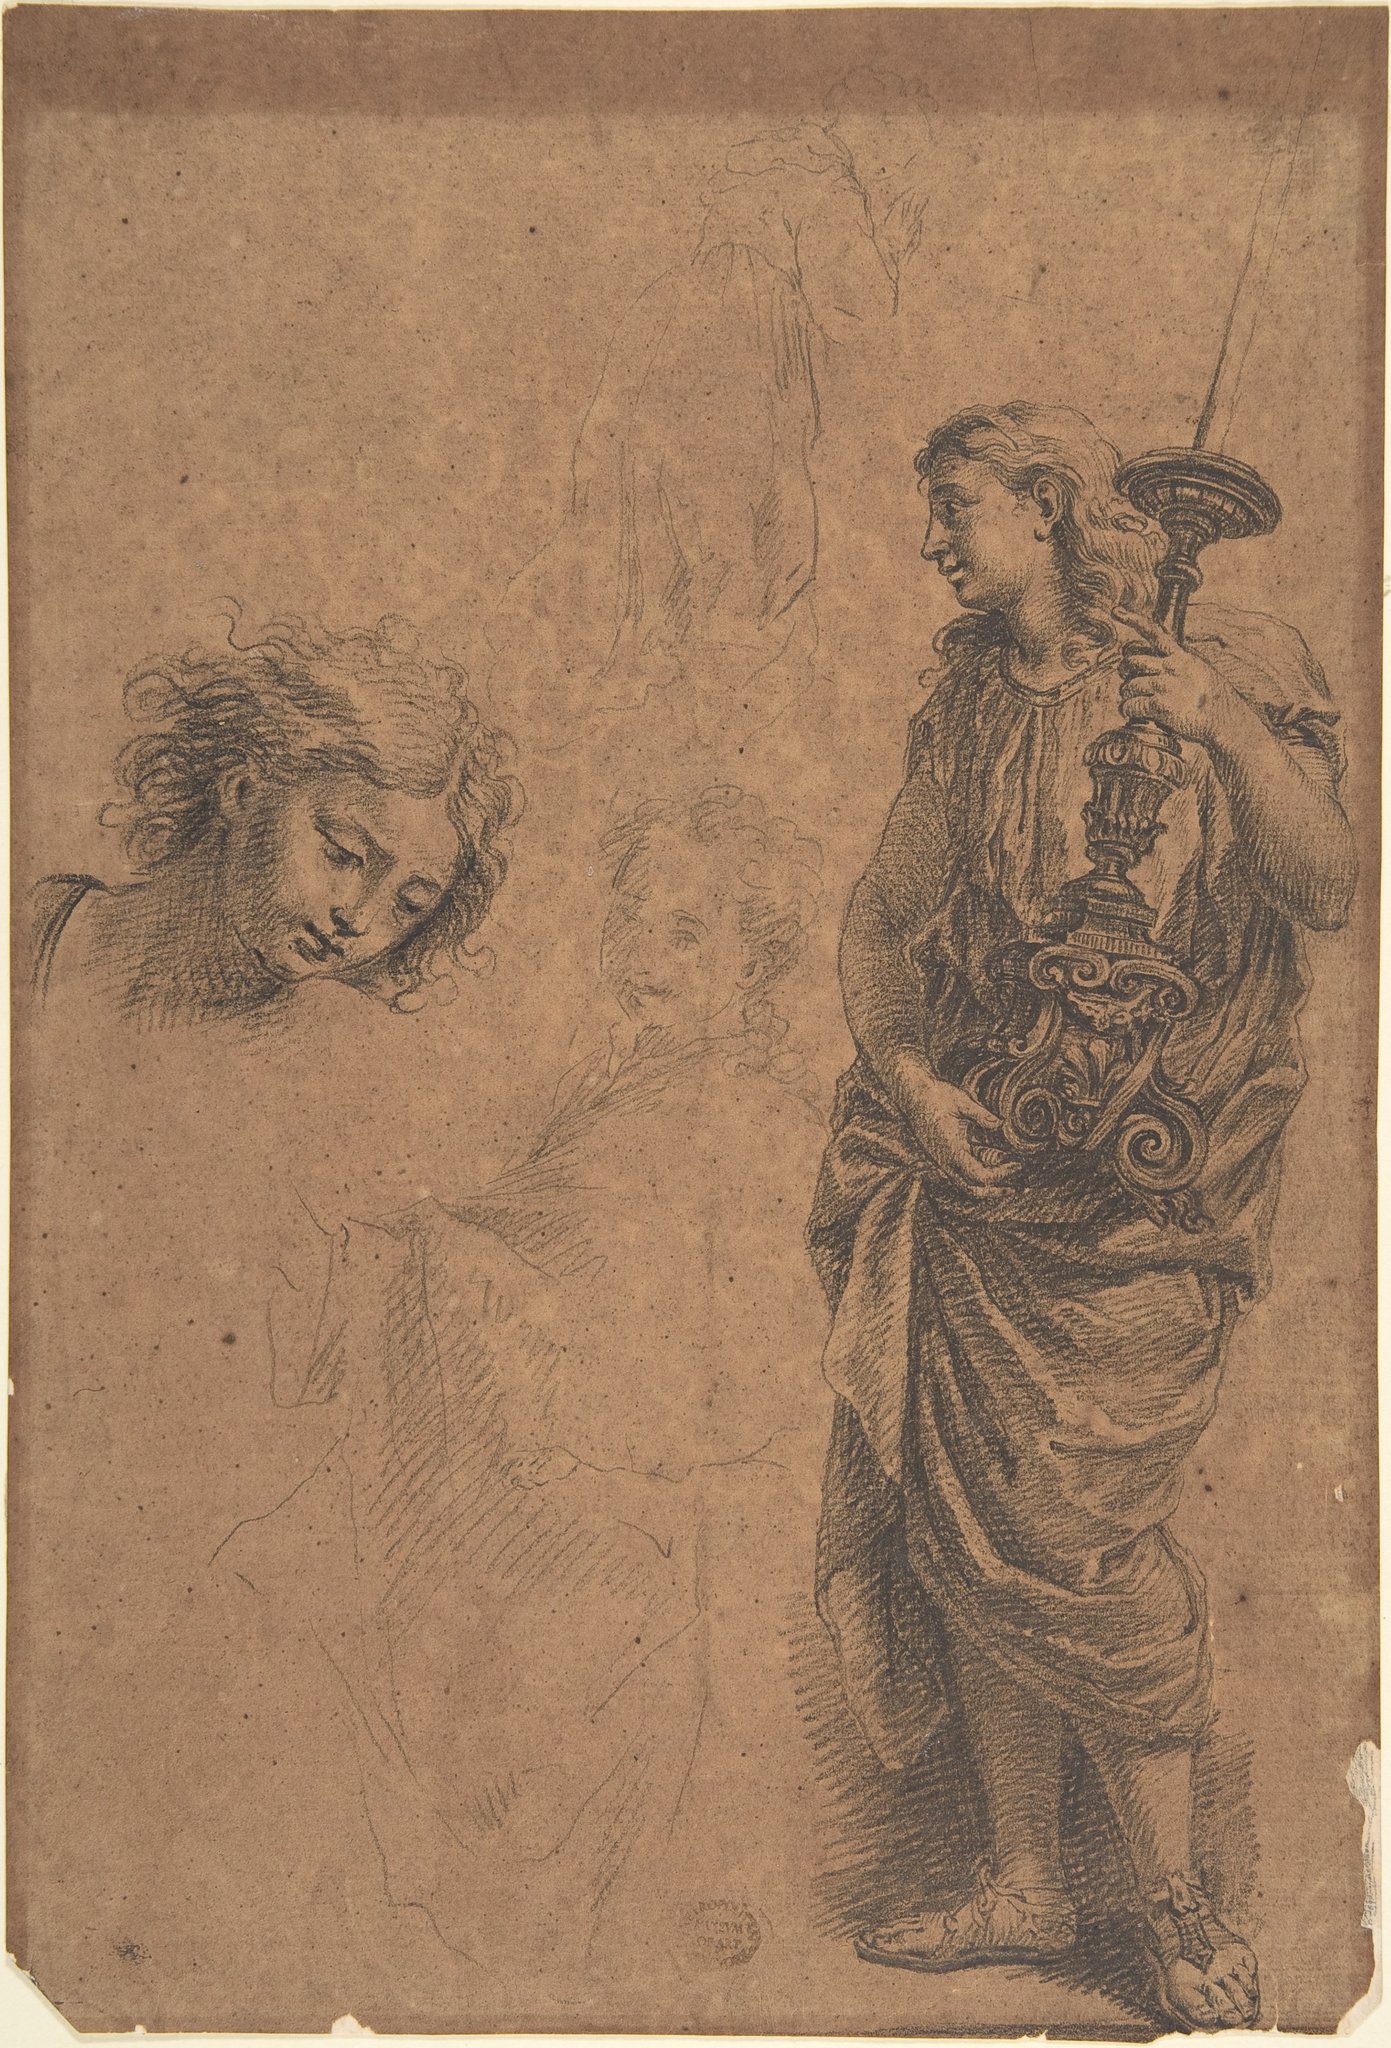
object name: drawing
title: Studies: Figure Holding a Candlestand, Woman with Left Arm Extended, Head Looking Down towards the Right, Kneeling Woman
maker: anonymous, italian, roman-bolognese, 17th century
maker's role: artist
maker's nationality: italian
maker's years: 1600-1700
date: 1601-1700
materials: chalk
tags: heads,women